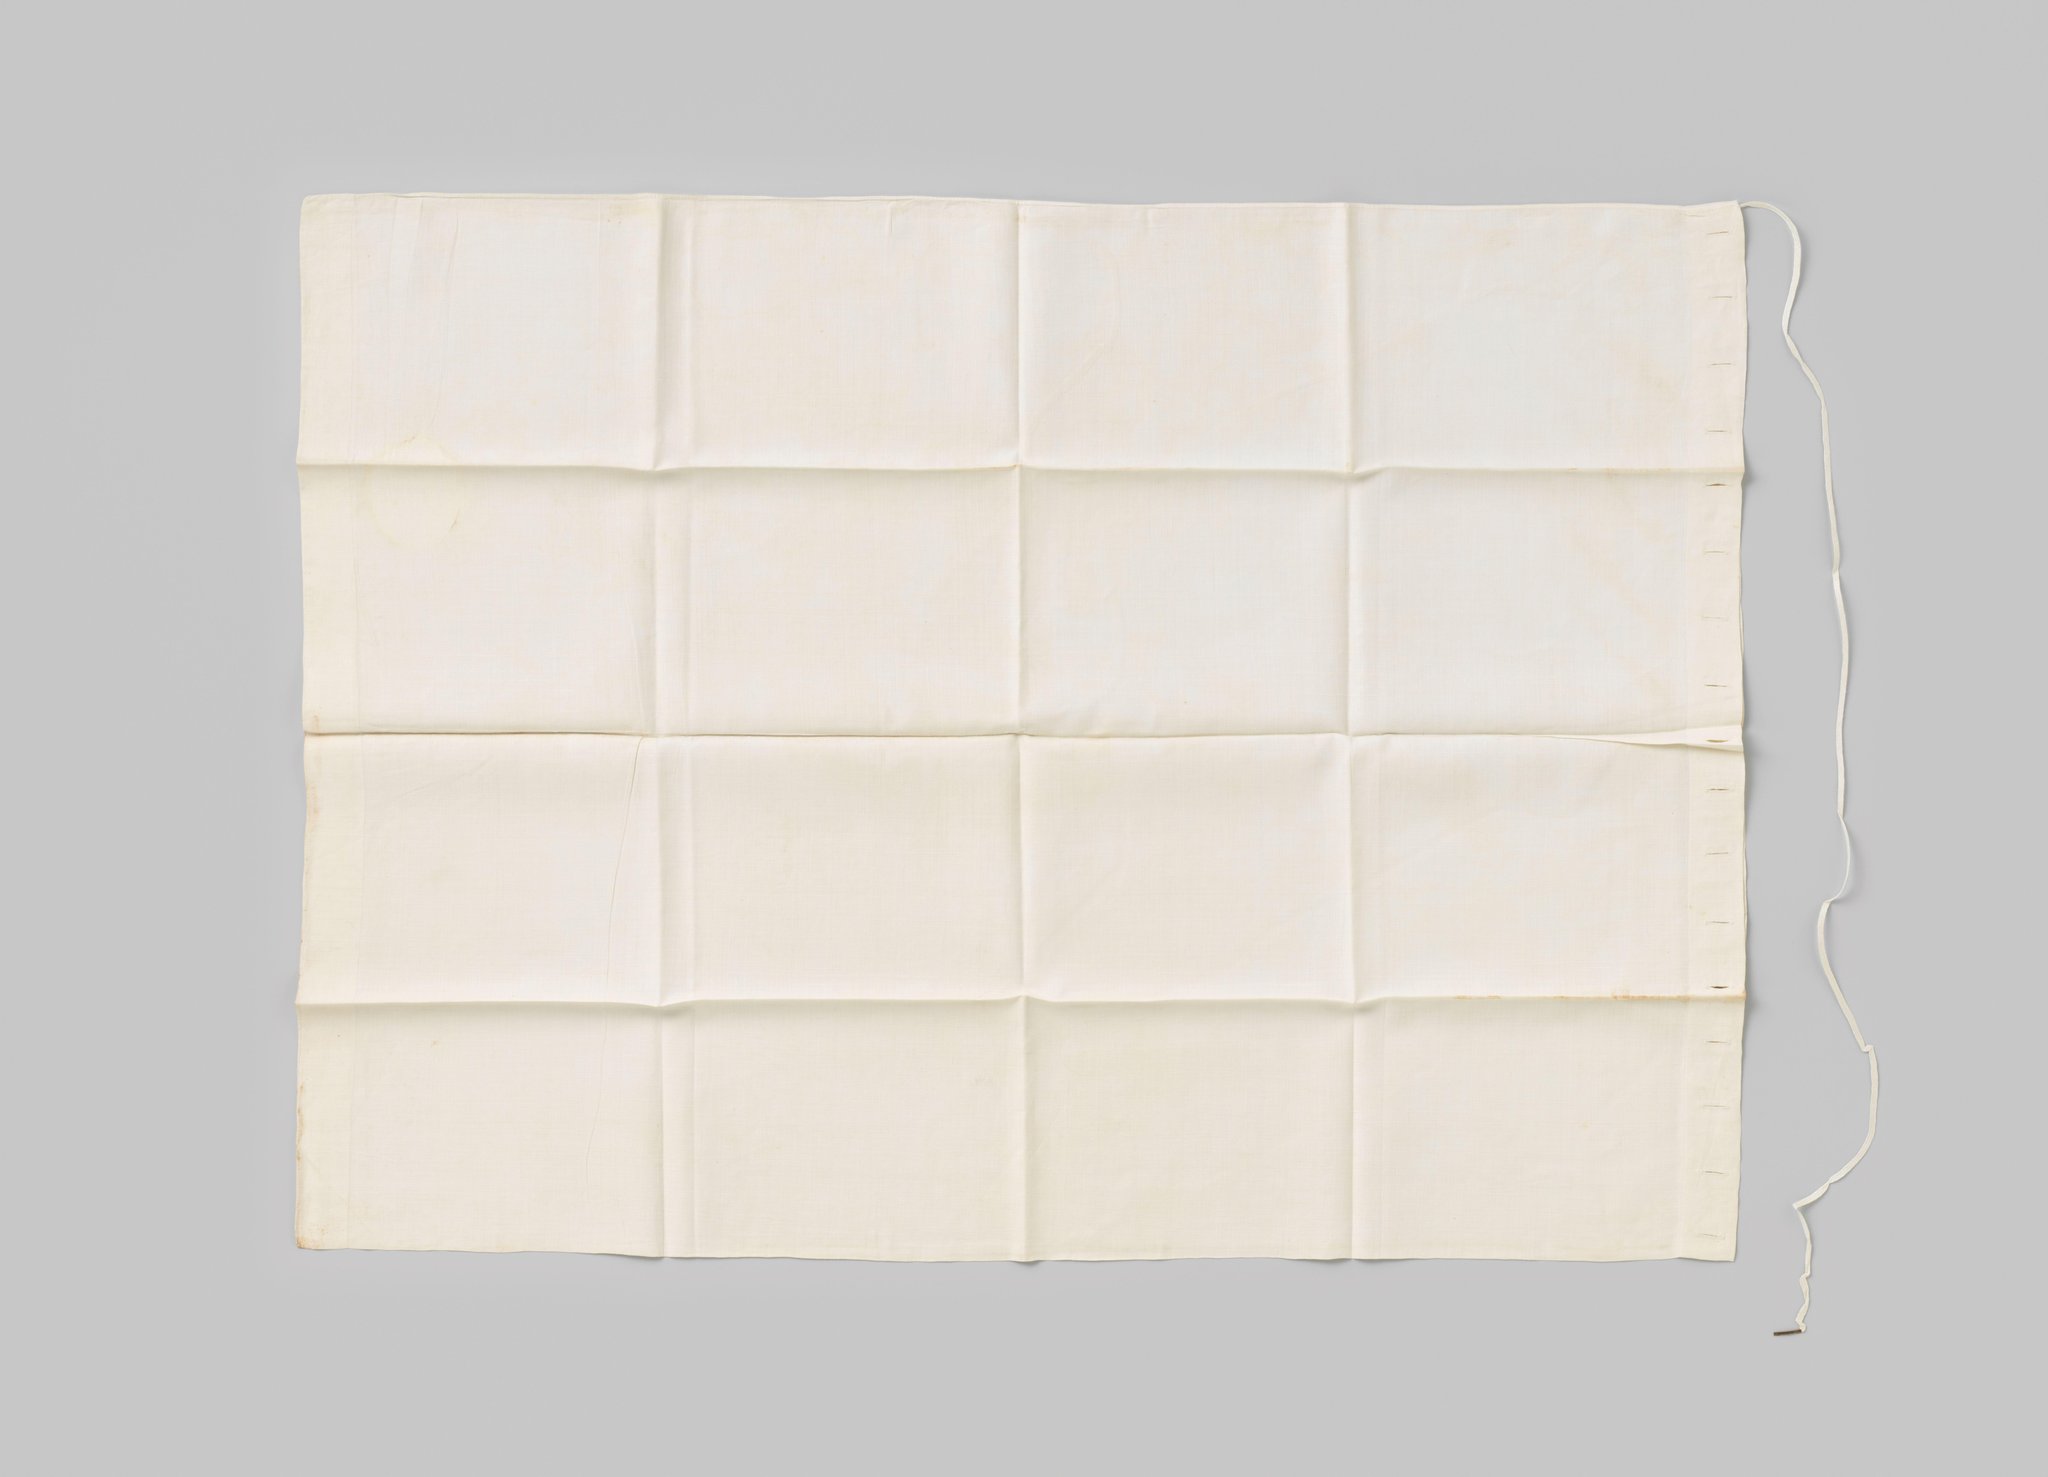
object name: sloop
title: Sloop van wit linnen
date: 1692-1735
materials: linen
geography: northern netherlands